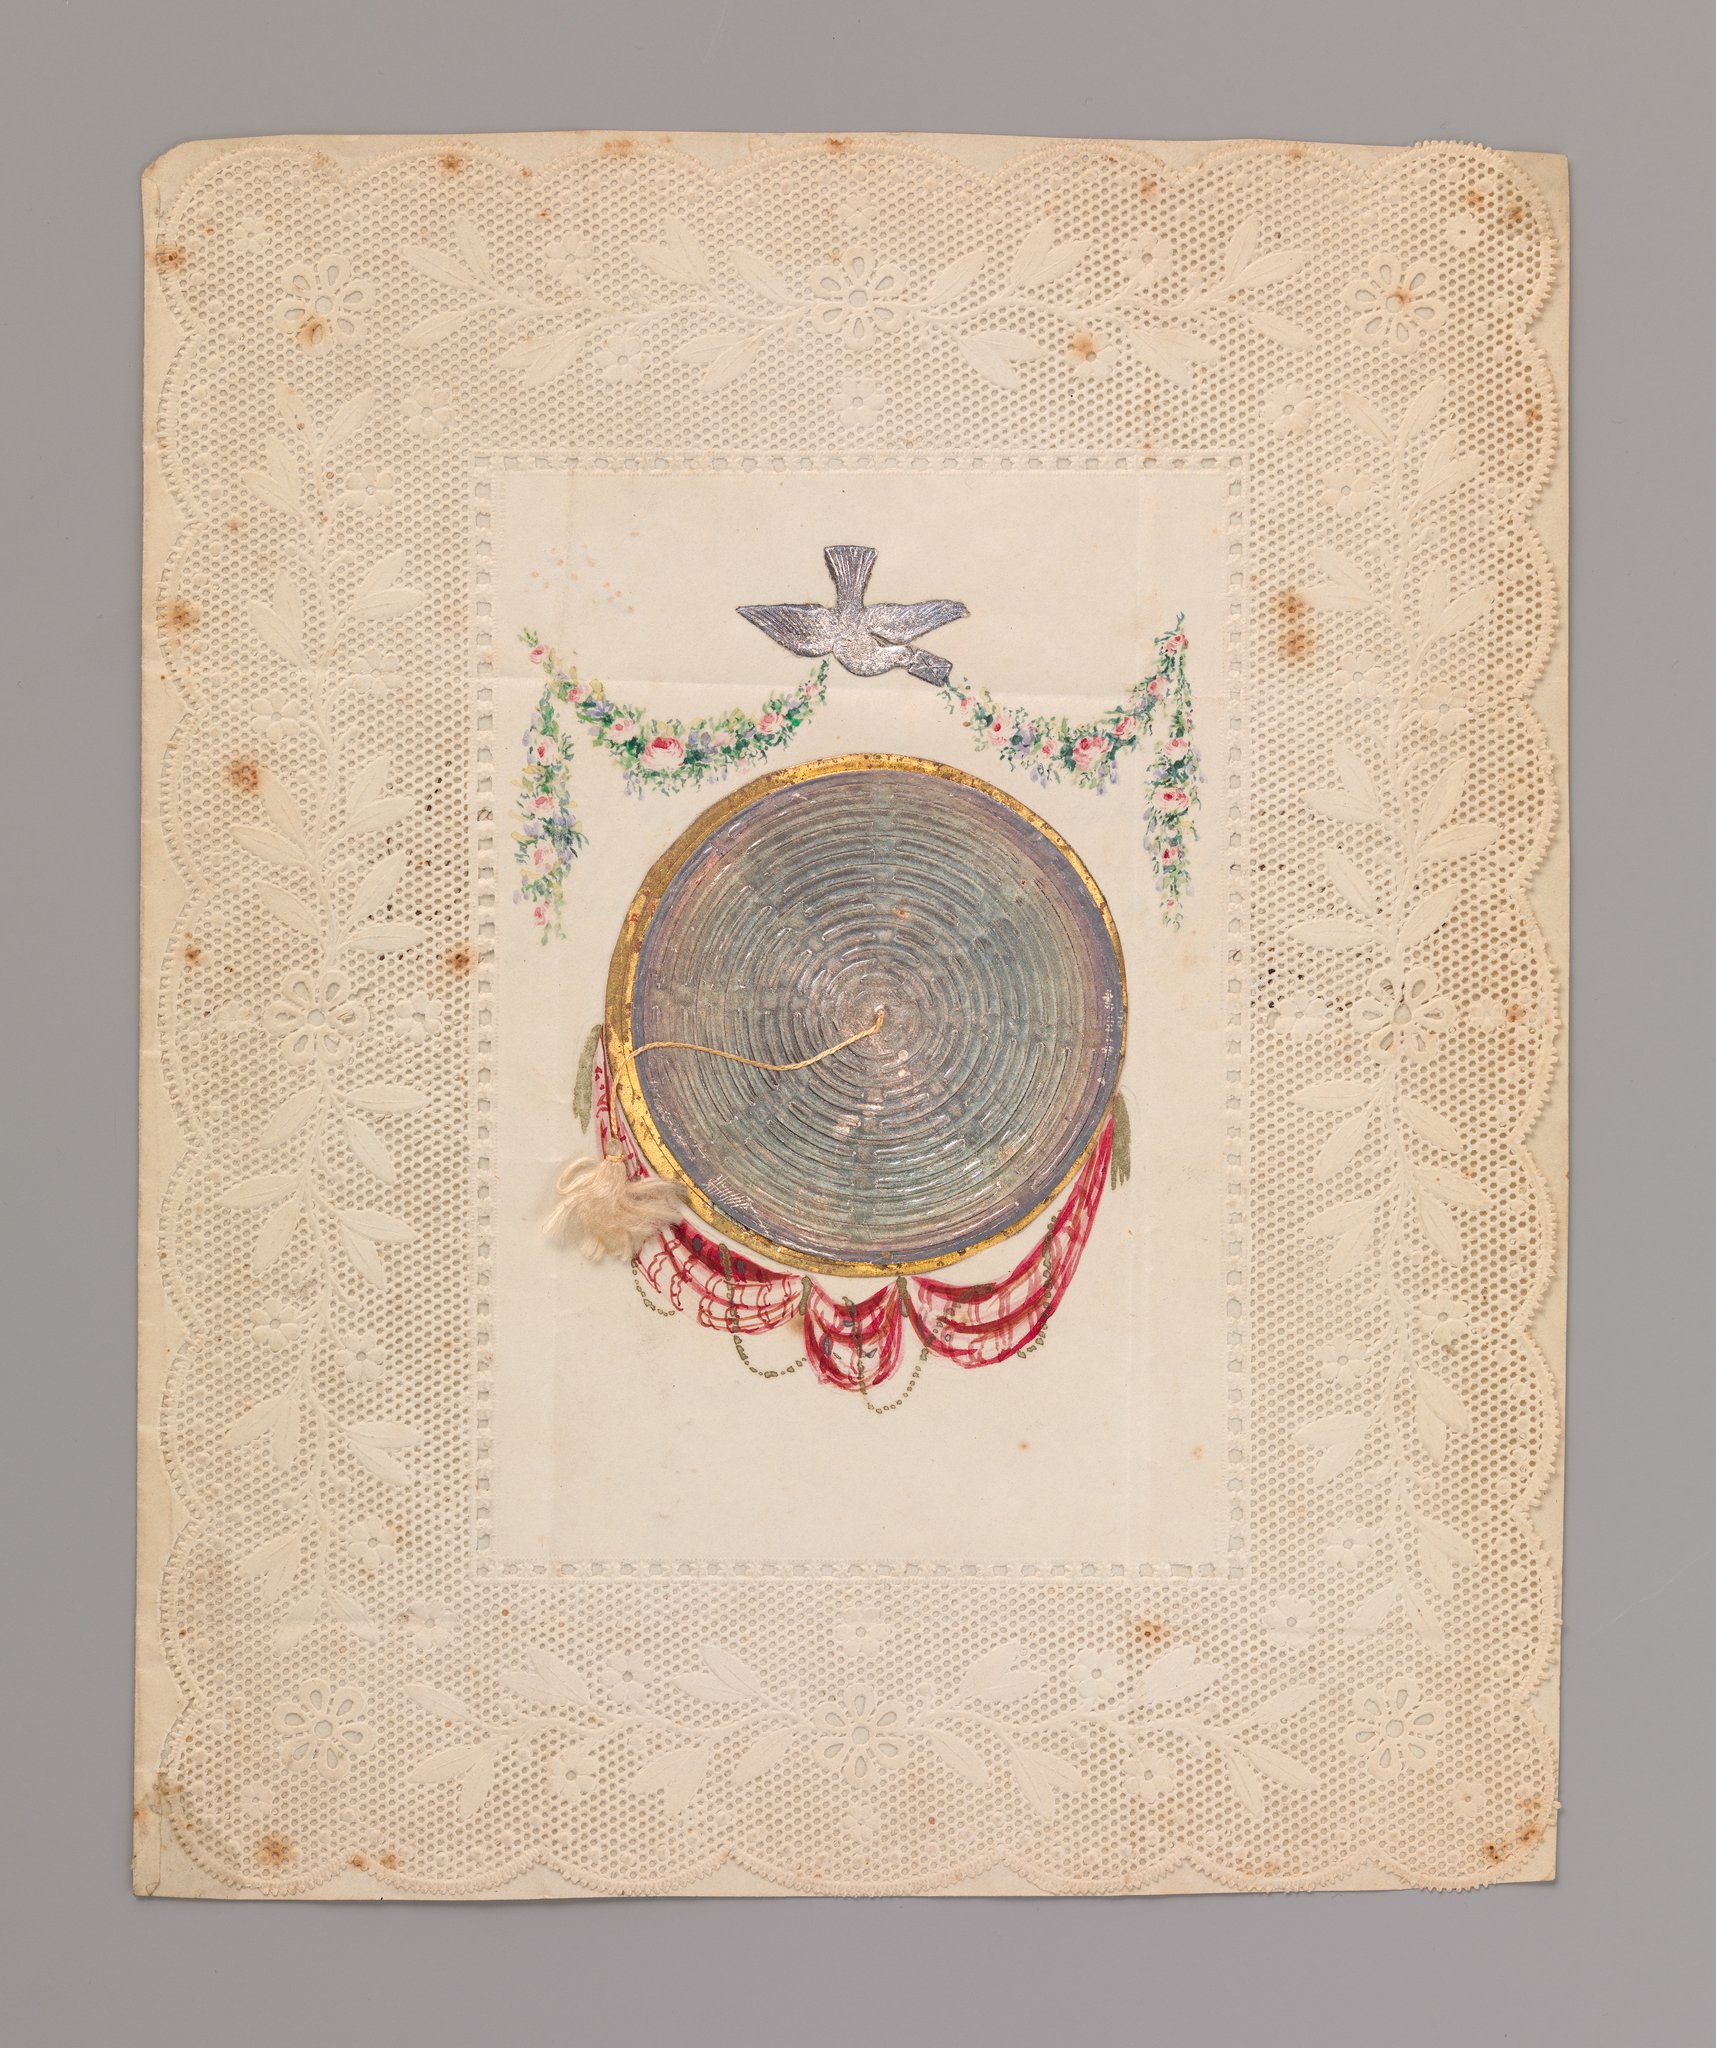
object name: valentine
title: Metallic Double Cobweb Valentine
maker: anonymous, british, 19th century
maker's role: artist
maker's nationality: british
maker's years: 1800-1900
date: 1845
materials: paper, watercolor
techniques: embossing, lithograph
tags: girls,fairies